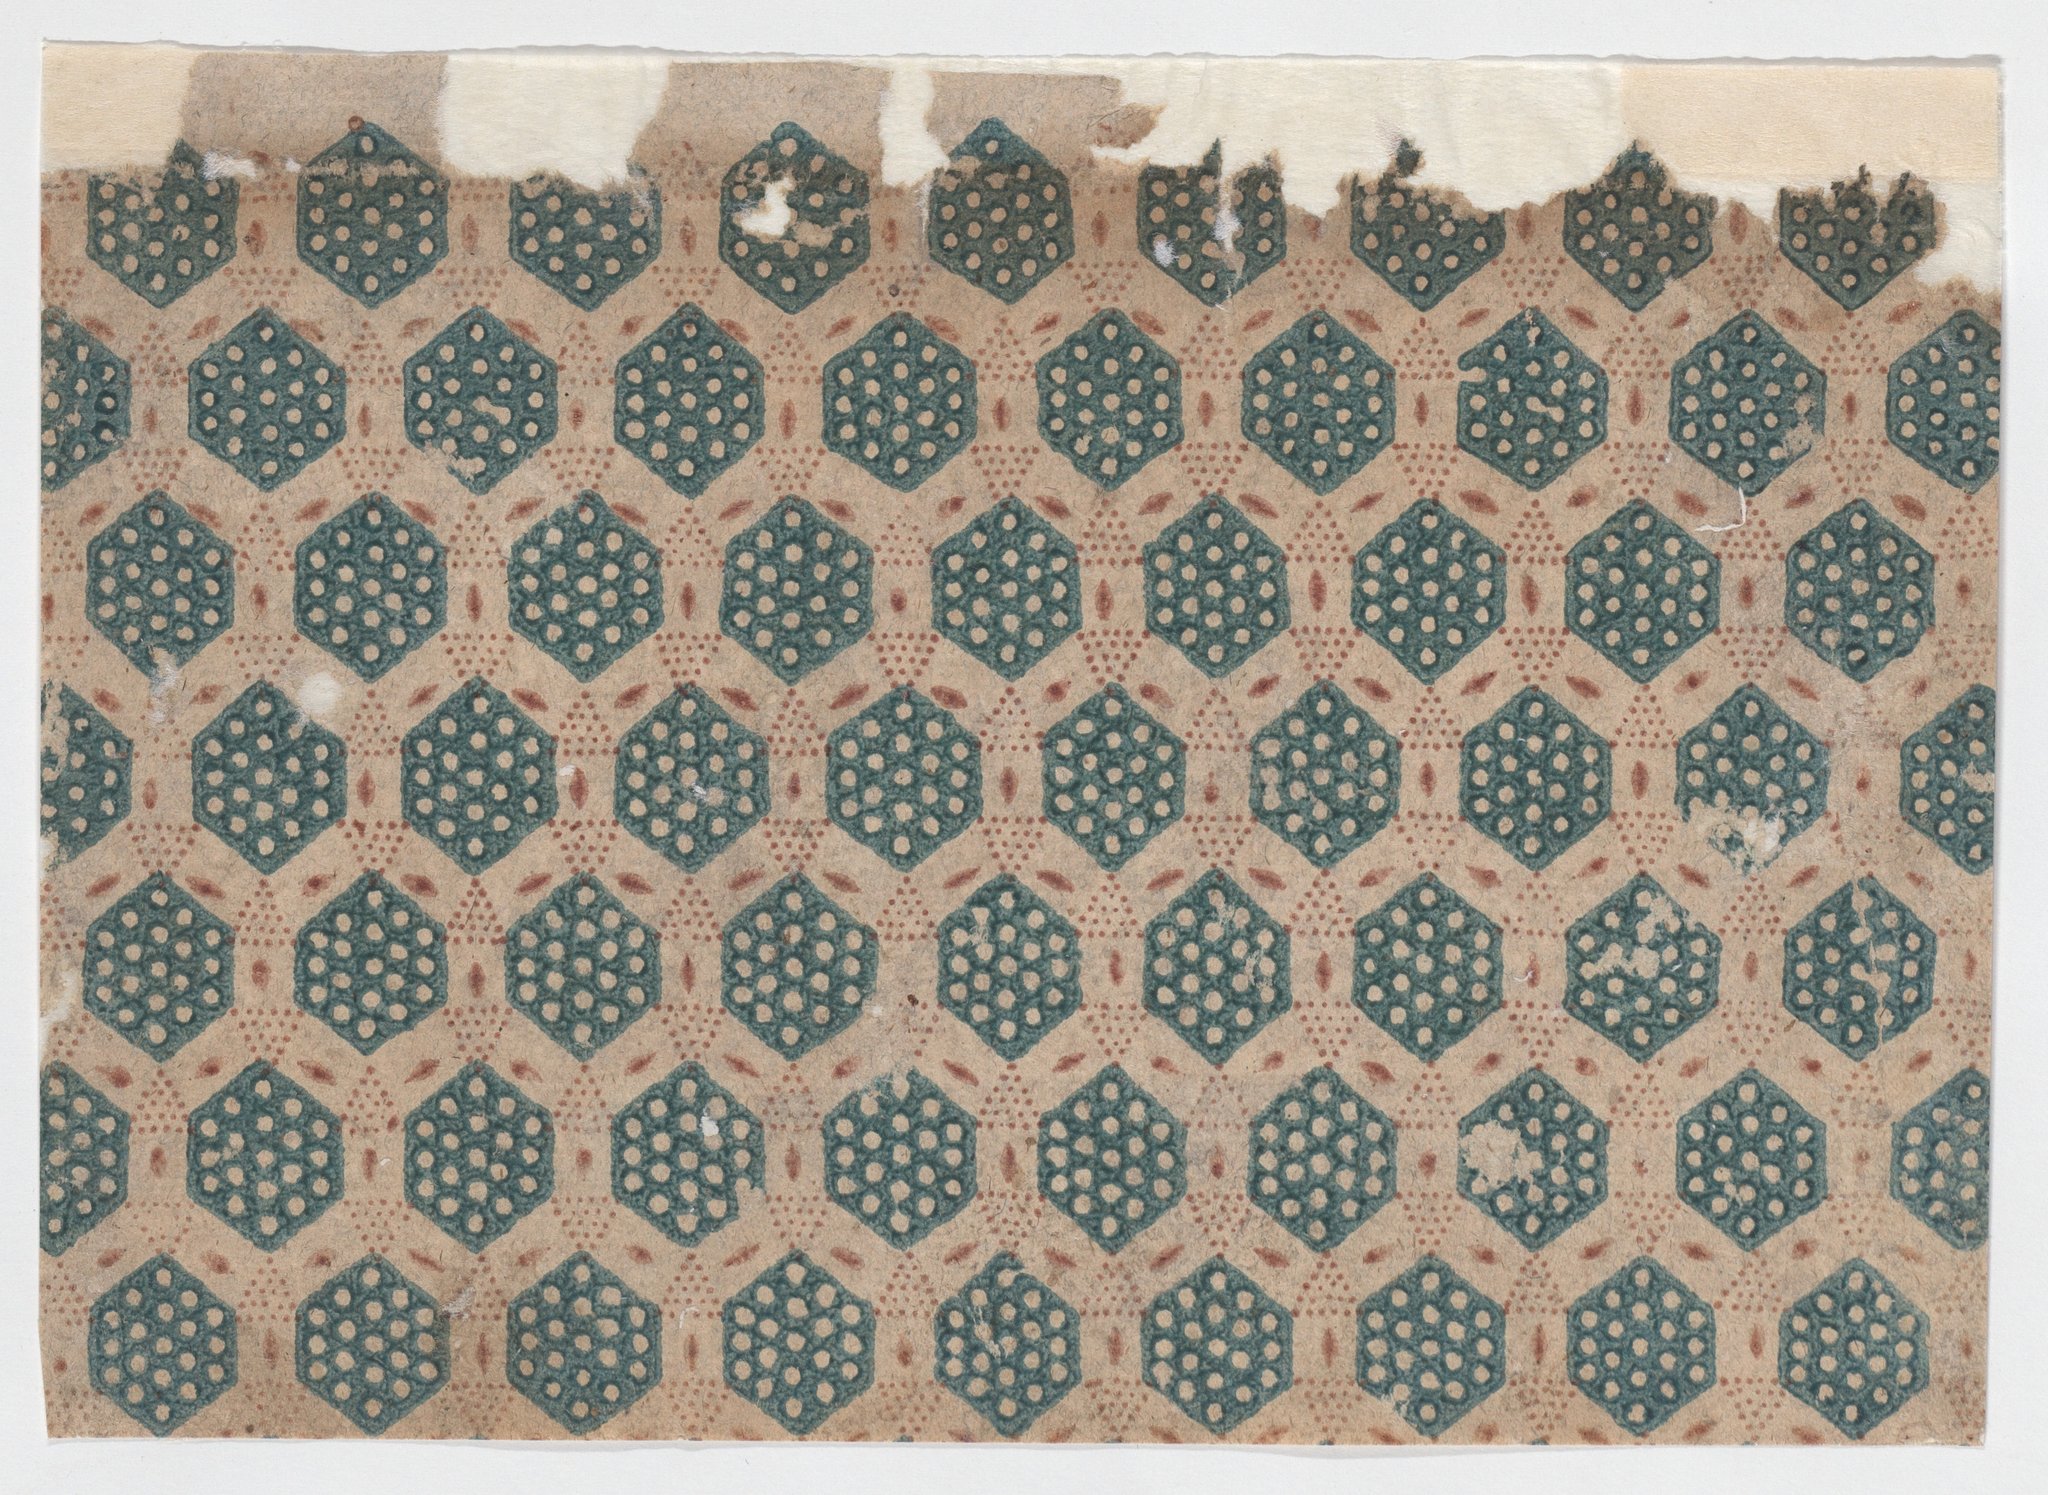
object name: print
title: Sheet with overall pattern of hexagonal shapes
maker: Anonymous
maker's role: artist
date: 1801-1900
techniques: relief print